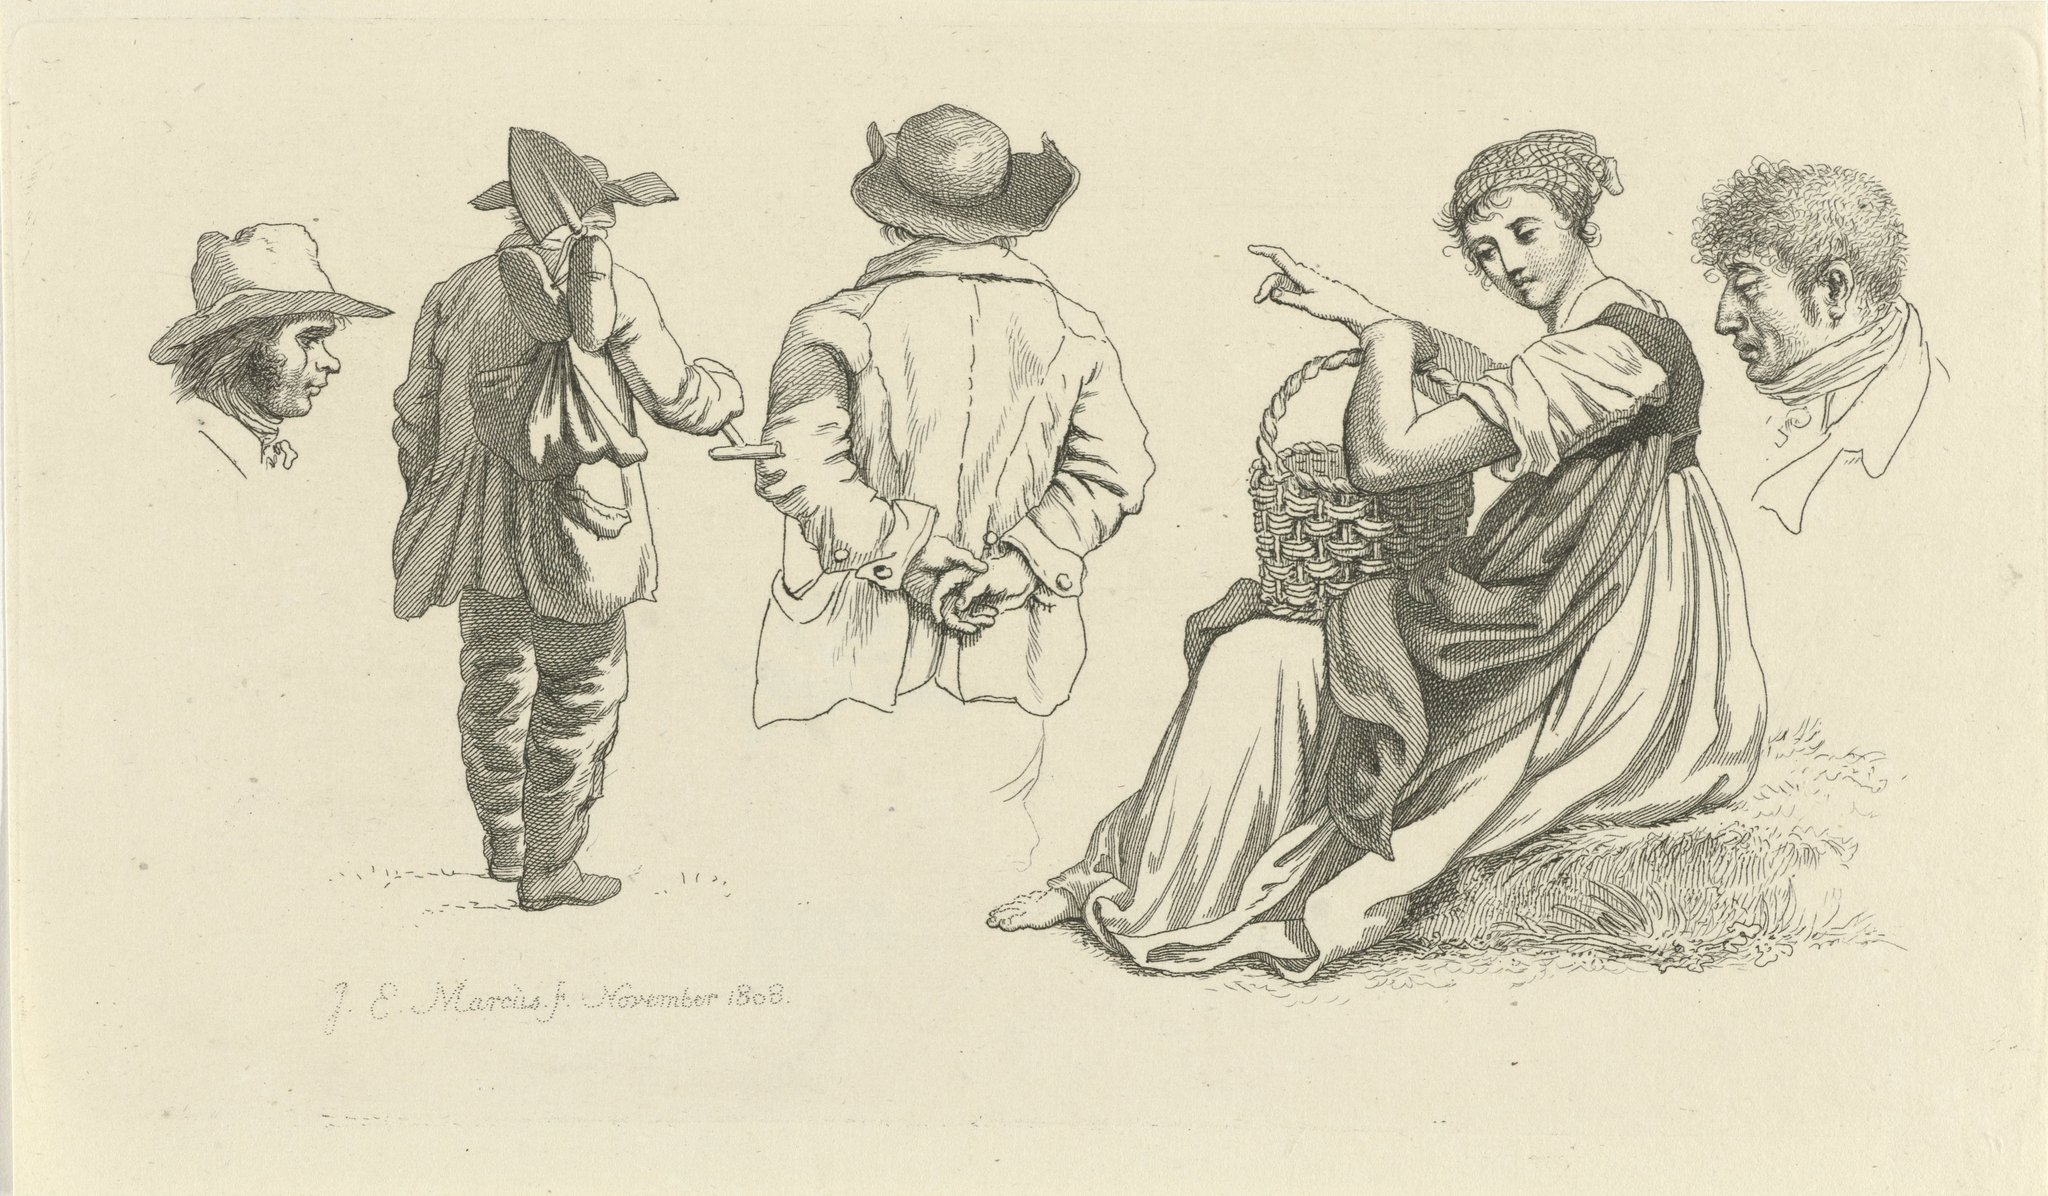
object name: print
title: Studieblad met een vrouw met een mand en figuren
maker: jacob ernst marcus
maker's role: draughtsman, print maker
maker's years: 1774-1826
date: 1808-1811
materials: paper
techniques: etching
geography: amsterdam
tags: sitting figure - aa - female human figure, container made of plant material other than wood: basket, agricultural implements: spade, standing figure (+ back view)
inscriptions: collector's mark: Lugt 2228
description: Serie voor het eerst uitgegeven door Jacob Ernst Marcus onder de titel Studiebeelden en Fragmenten. Amsterdam: ca.1816. Later heruitgegeven als: Studie-prentwerk/ Etudes gravées.